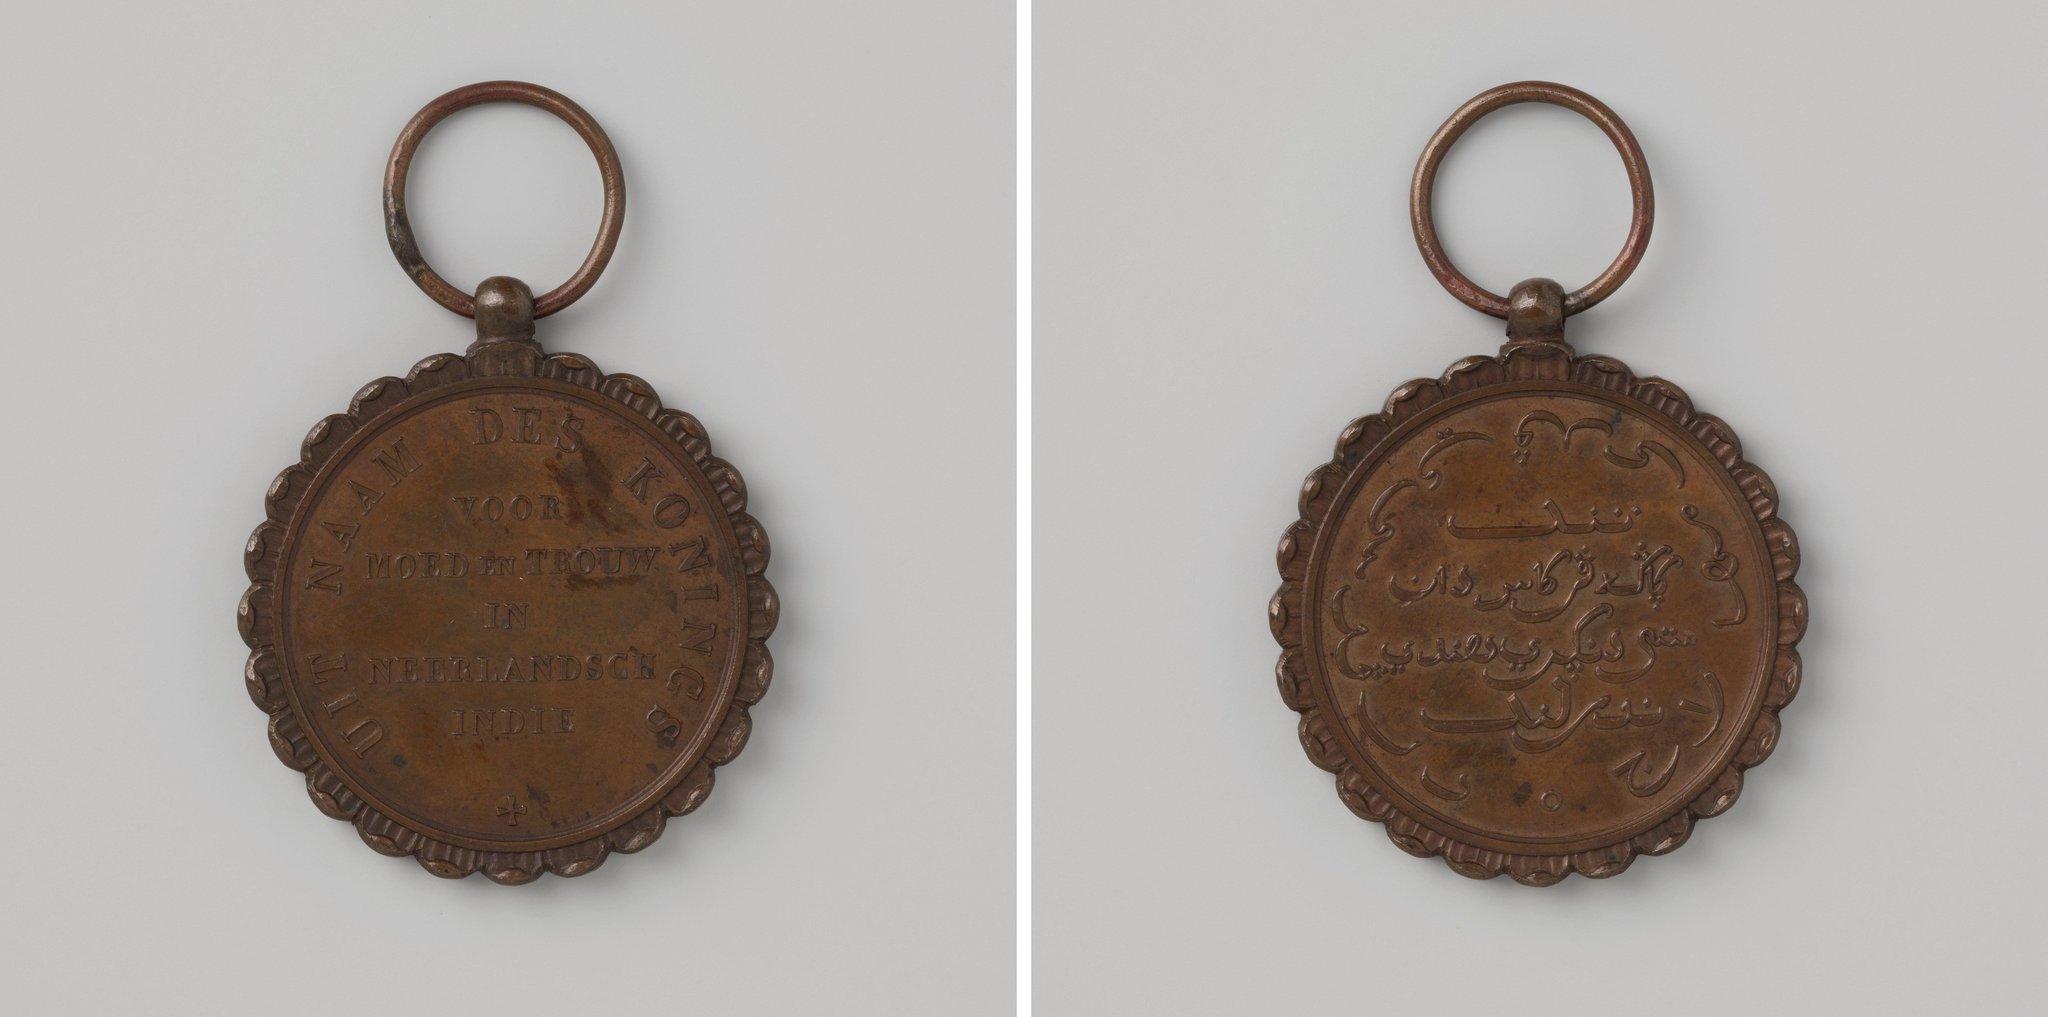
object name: history medal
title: Medaille voor Moed en Trouw, bronzen afslag, 1839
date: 1839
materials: bronze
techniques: striking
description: Bronzen penning met schulprand met bal en draagring, op de voorzijde vijf regels tekst met omschrift, op de keerzijde vier regels tekst met omschrift in Perzisch schrift.